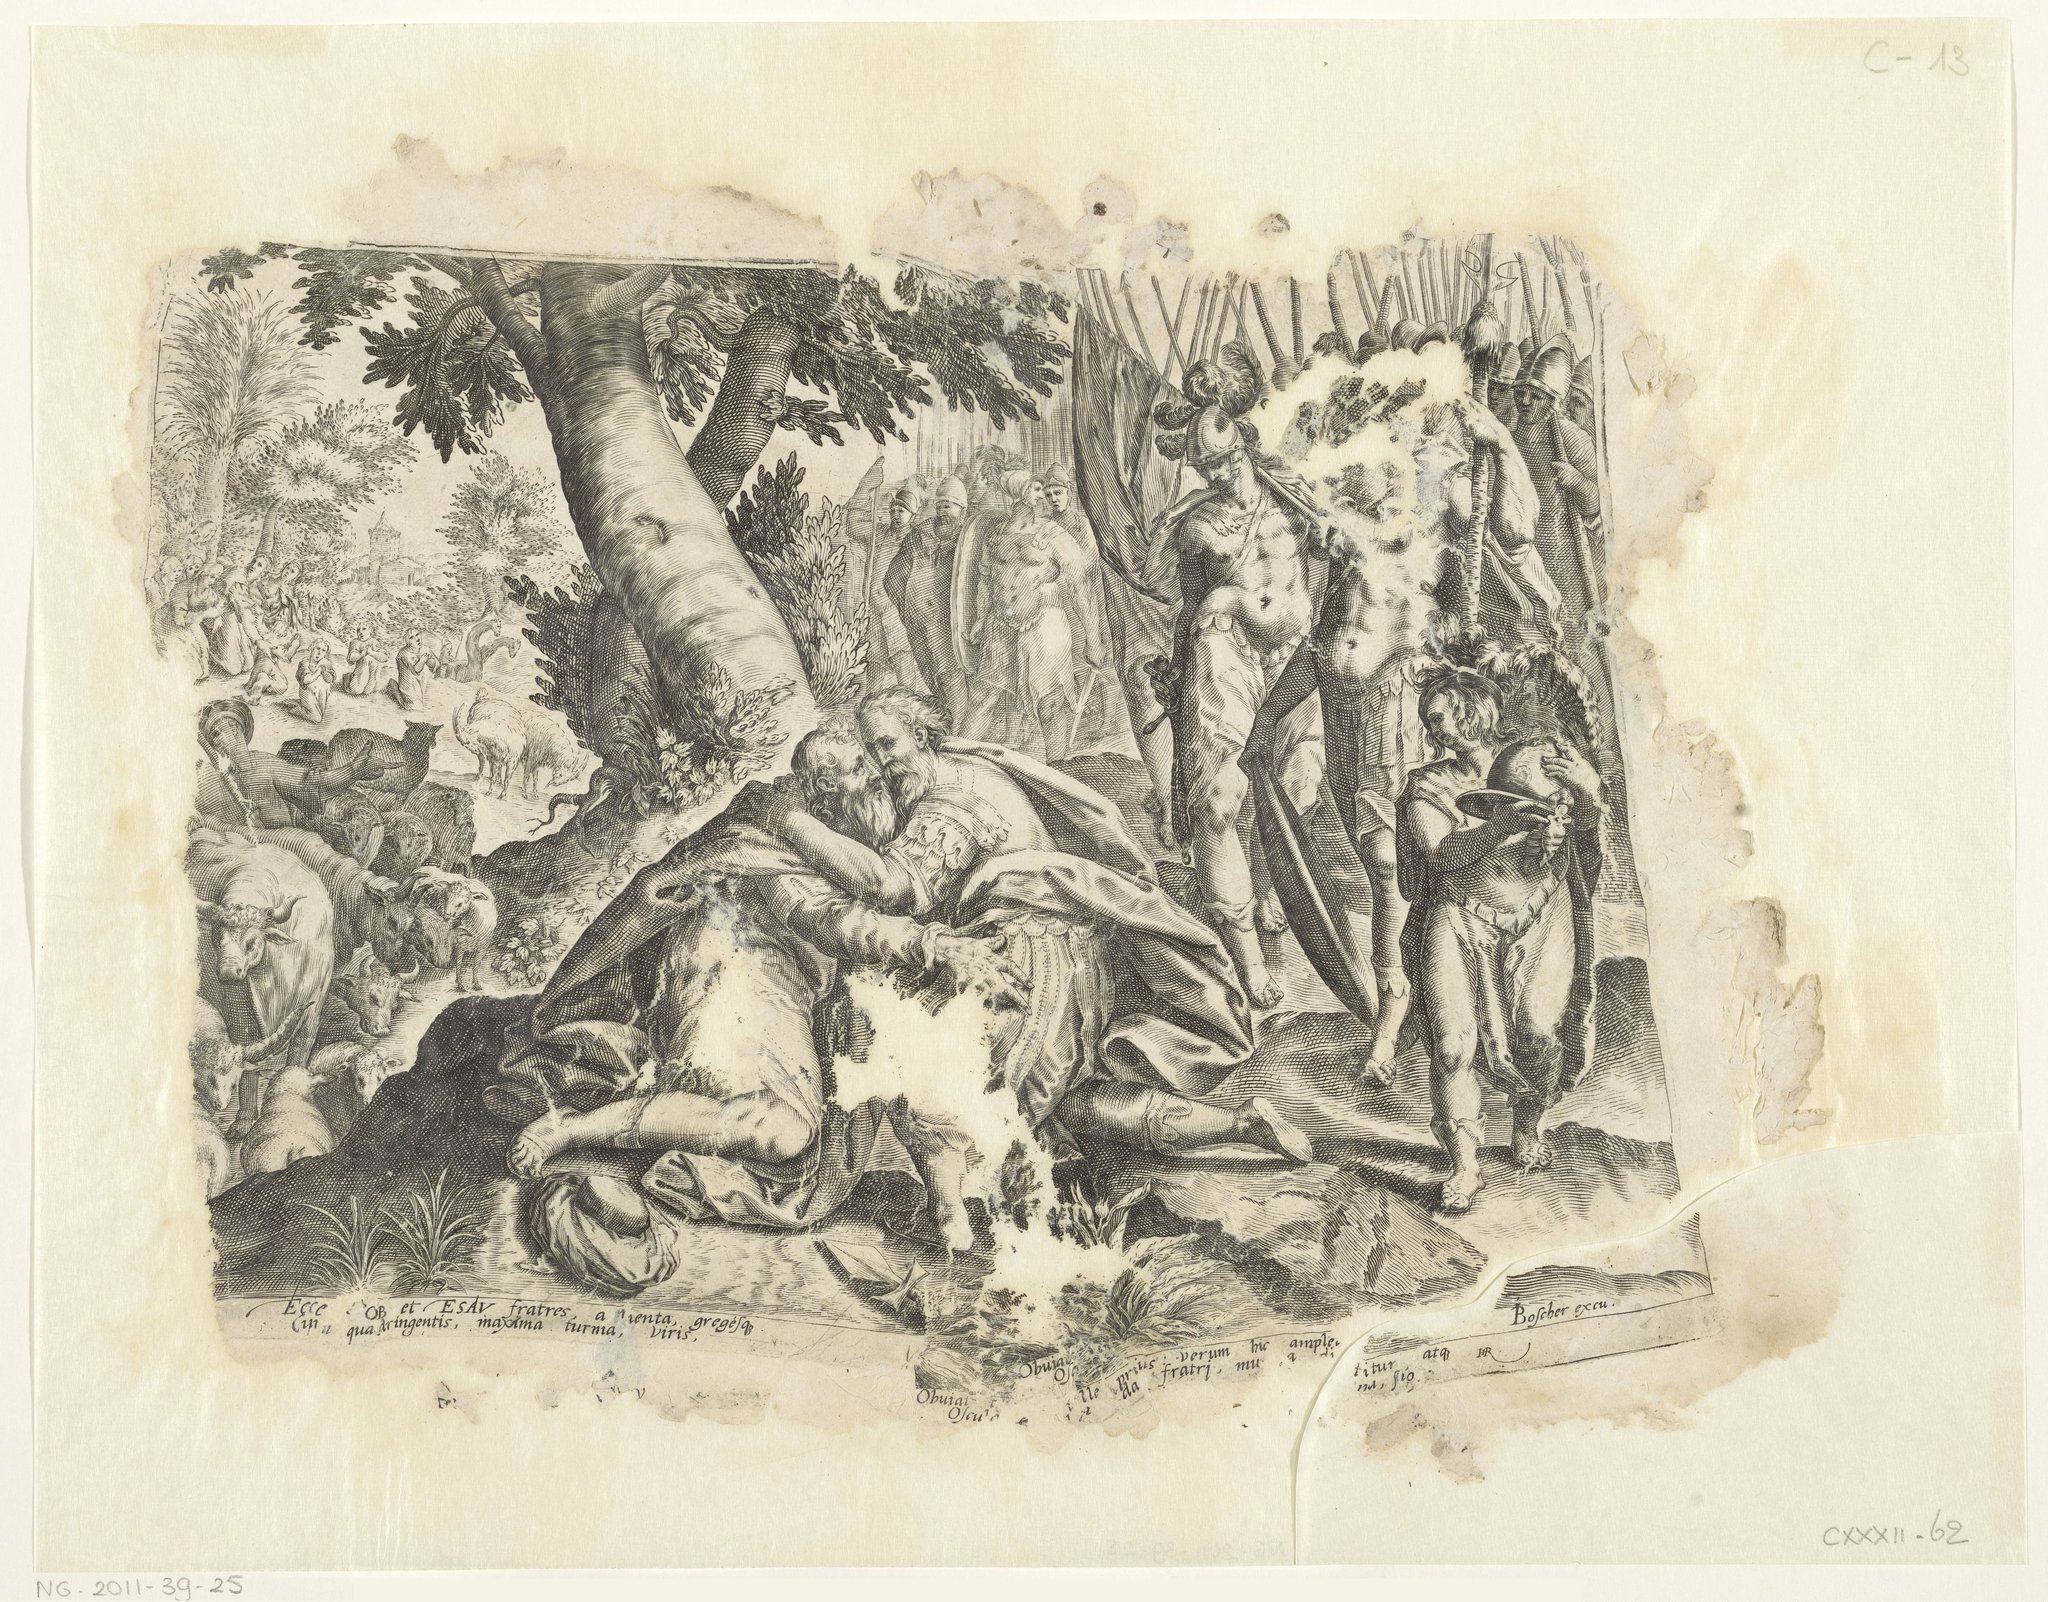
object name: print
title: Verzoening van Jakob en Esau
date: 1580-1596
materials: paper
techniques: engraving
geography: northern netherlands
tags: the meeting between esau and jacob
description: Tot dusverre was deze prent alleen bekend in een latere editie met het adres van C.J. Visscher in het door hem uitgegeven Theatrum Biblicum uit 1643, zie RP-P-1976-30-39. De prenten in de Nova Zembla collectie zijn tijdens een expeditie van Willem Barendsz en Jacob van Heemskerk in 1596-1597 noodgedwongen in het winterkamp, het ‘Behouden Huis’, op het eiland achtergelaten. De prenten waren in één of meerdere stapels als handelswaar meegenomen vanuit Amsterdam. Bijna drie eeuwen later, in 1871, keerde de Noor Elling Carlsen terug naar Nova Zembla en vond daar de restanten van het ‘Behouden Huis, inclusief een groot deel van de inventaris. Een deel van de prenten, in de vorm van aaneengekoekte kluiten, werd toen ook teruggevonden. De papierkluiten waren soms op meerdere plekken gebroken. Tussen 1975-1979 zijn de prenten van elkaar gescheiden. Dit leverde in totaal ca. 1000 fragmenten van ca. 400 afdrukken van ca. 150 verschillende prenten op. Voor zover mogelijk zijn de fragmenten samengevoegd en zijn de prenten gereconstrueerd.